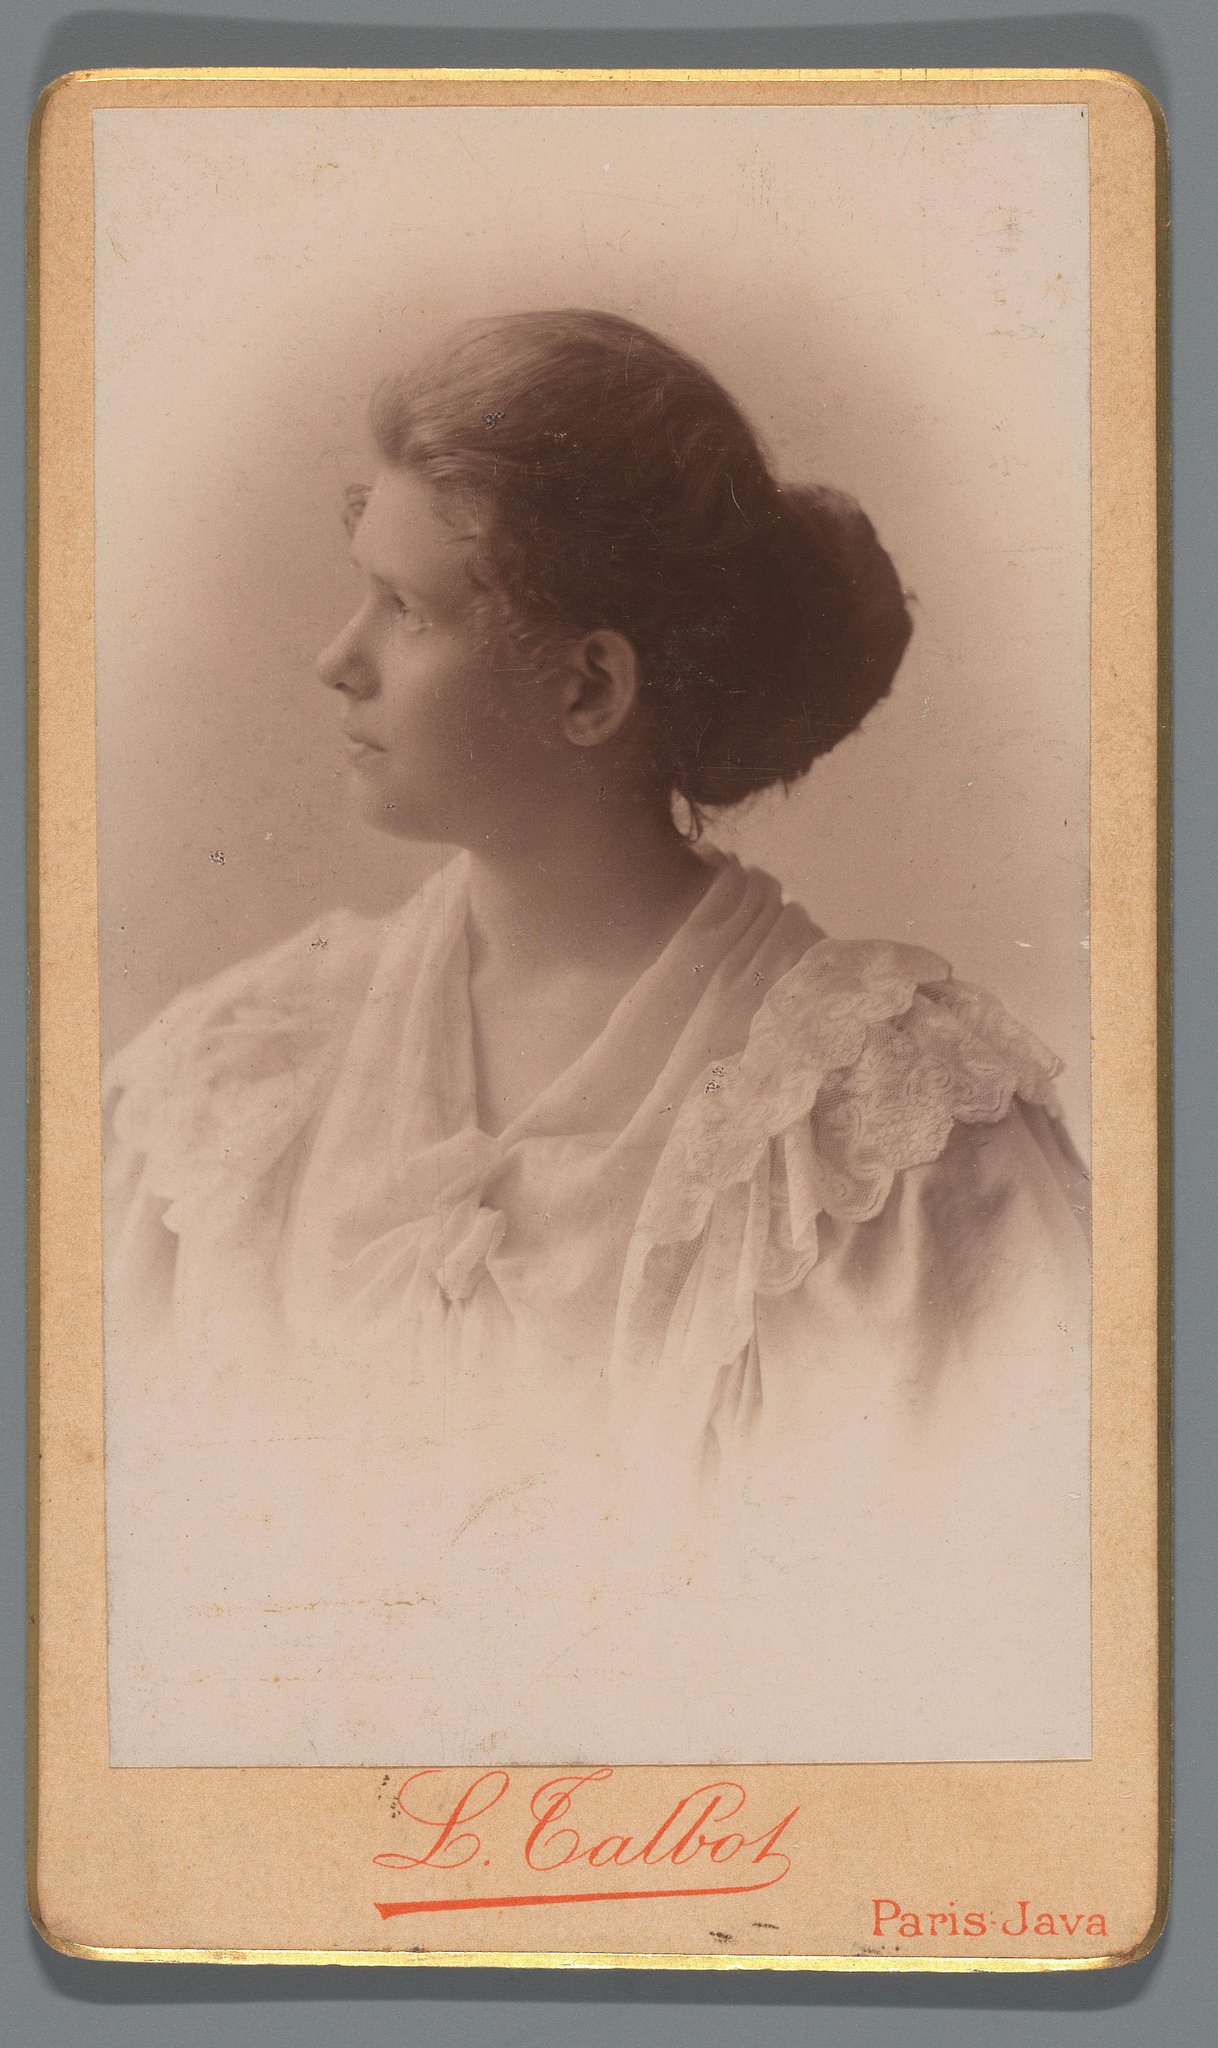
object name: photograph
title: Portret van tante Leo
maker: louis joseph isidore talbot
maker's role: fotograaf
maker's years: 1852-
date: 1890-1900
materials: cardboard, photographic support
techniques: albumen print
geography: batavia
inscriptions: name: ‘L. Talbot / Paris.Java’, inscription: ‘tante Leo’, name: ‘L. Talbot / Paris-Java’